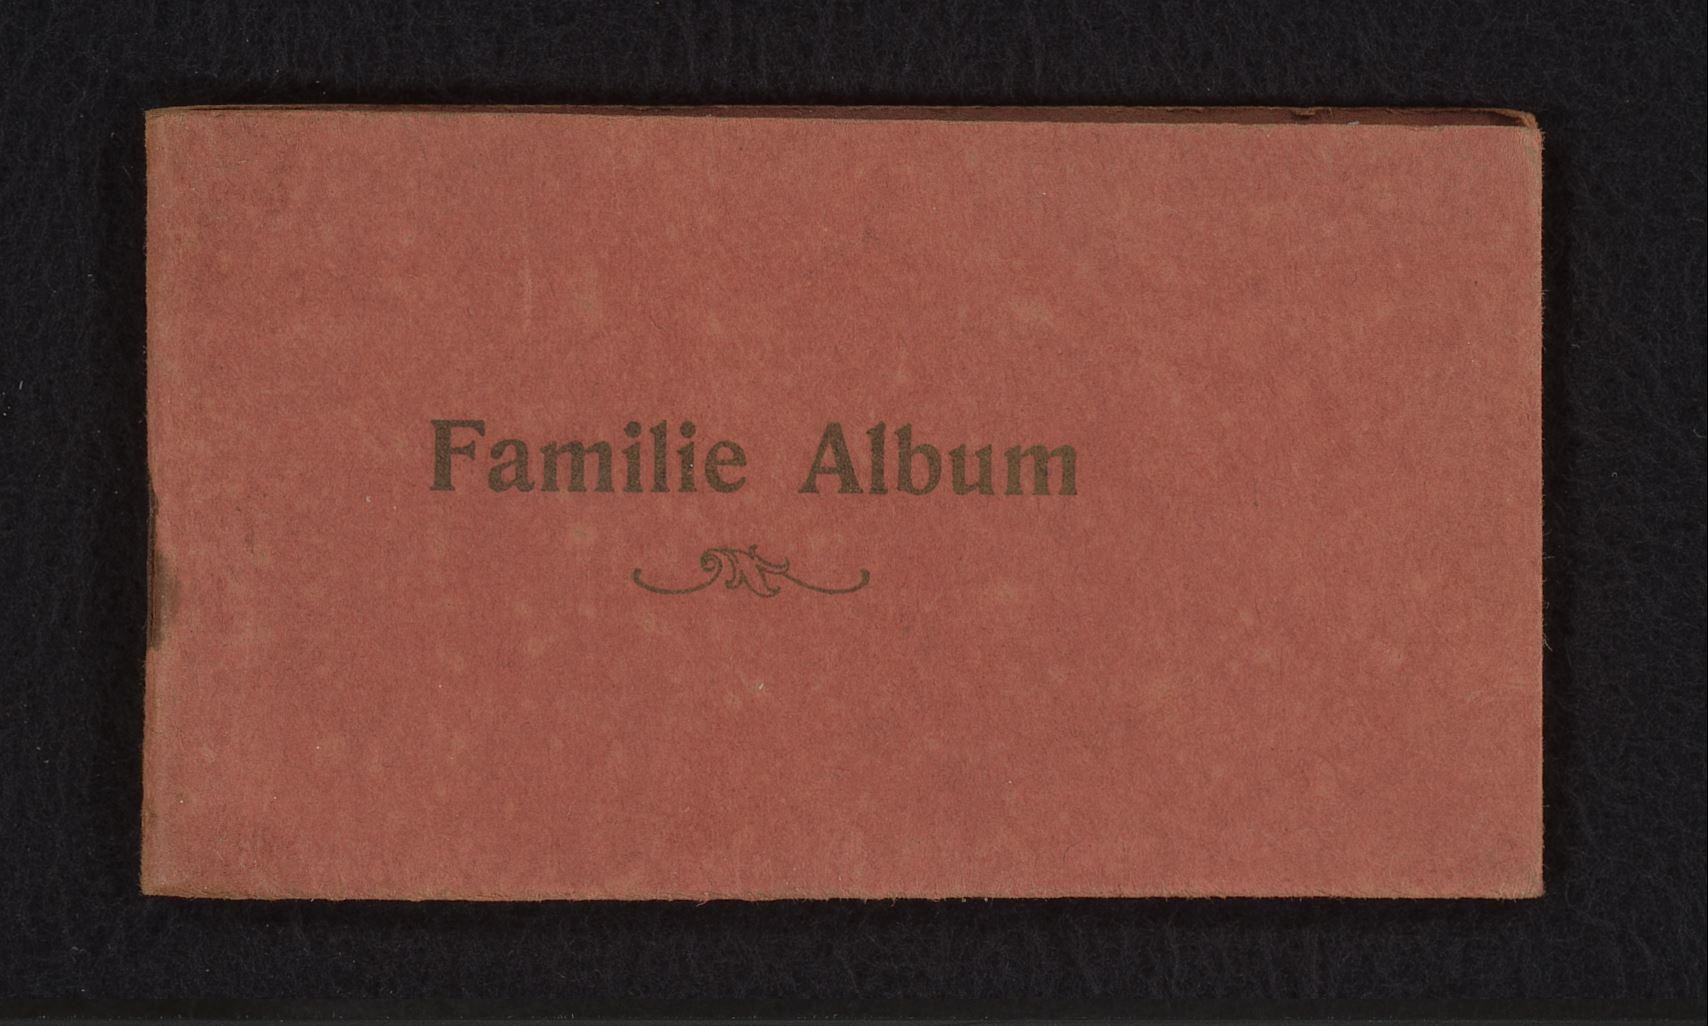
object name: photograph album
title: Familie Album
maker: Anonymous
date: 1900-1925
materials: cardboard, paper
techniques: printing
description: Fotoalbum met 12 bladen met op ieder blad naast elkaar twee rode rechthoeken met insteekhoeken om foto's van 40 x 35 mm in te plaatsen. In totaal is er in het album plaats voor 24 foto's.